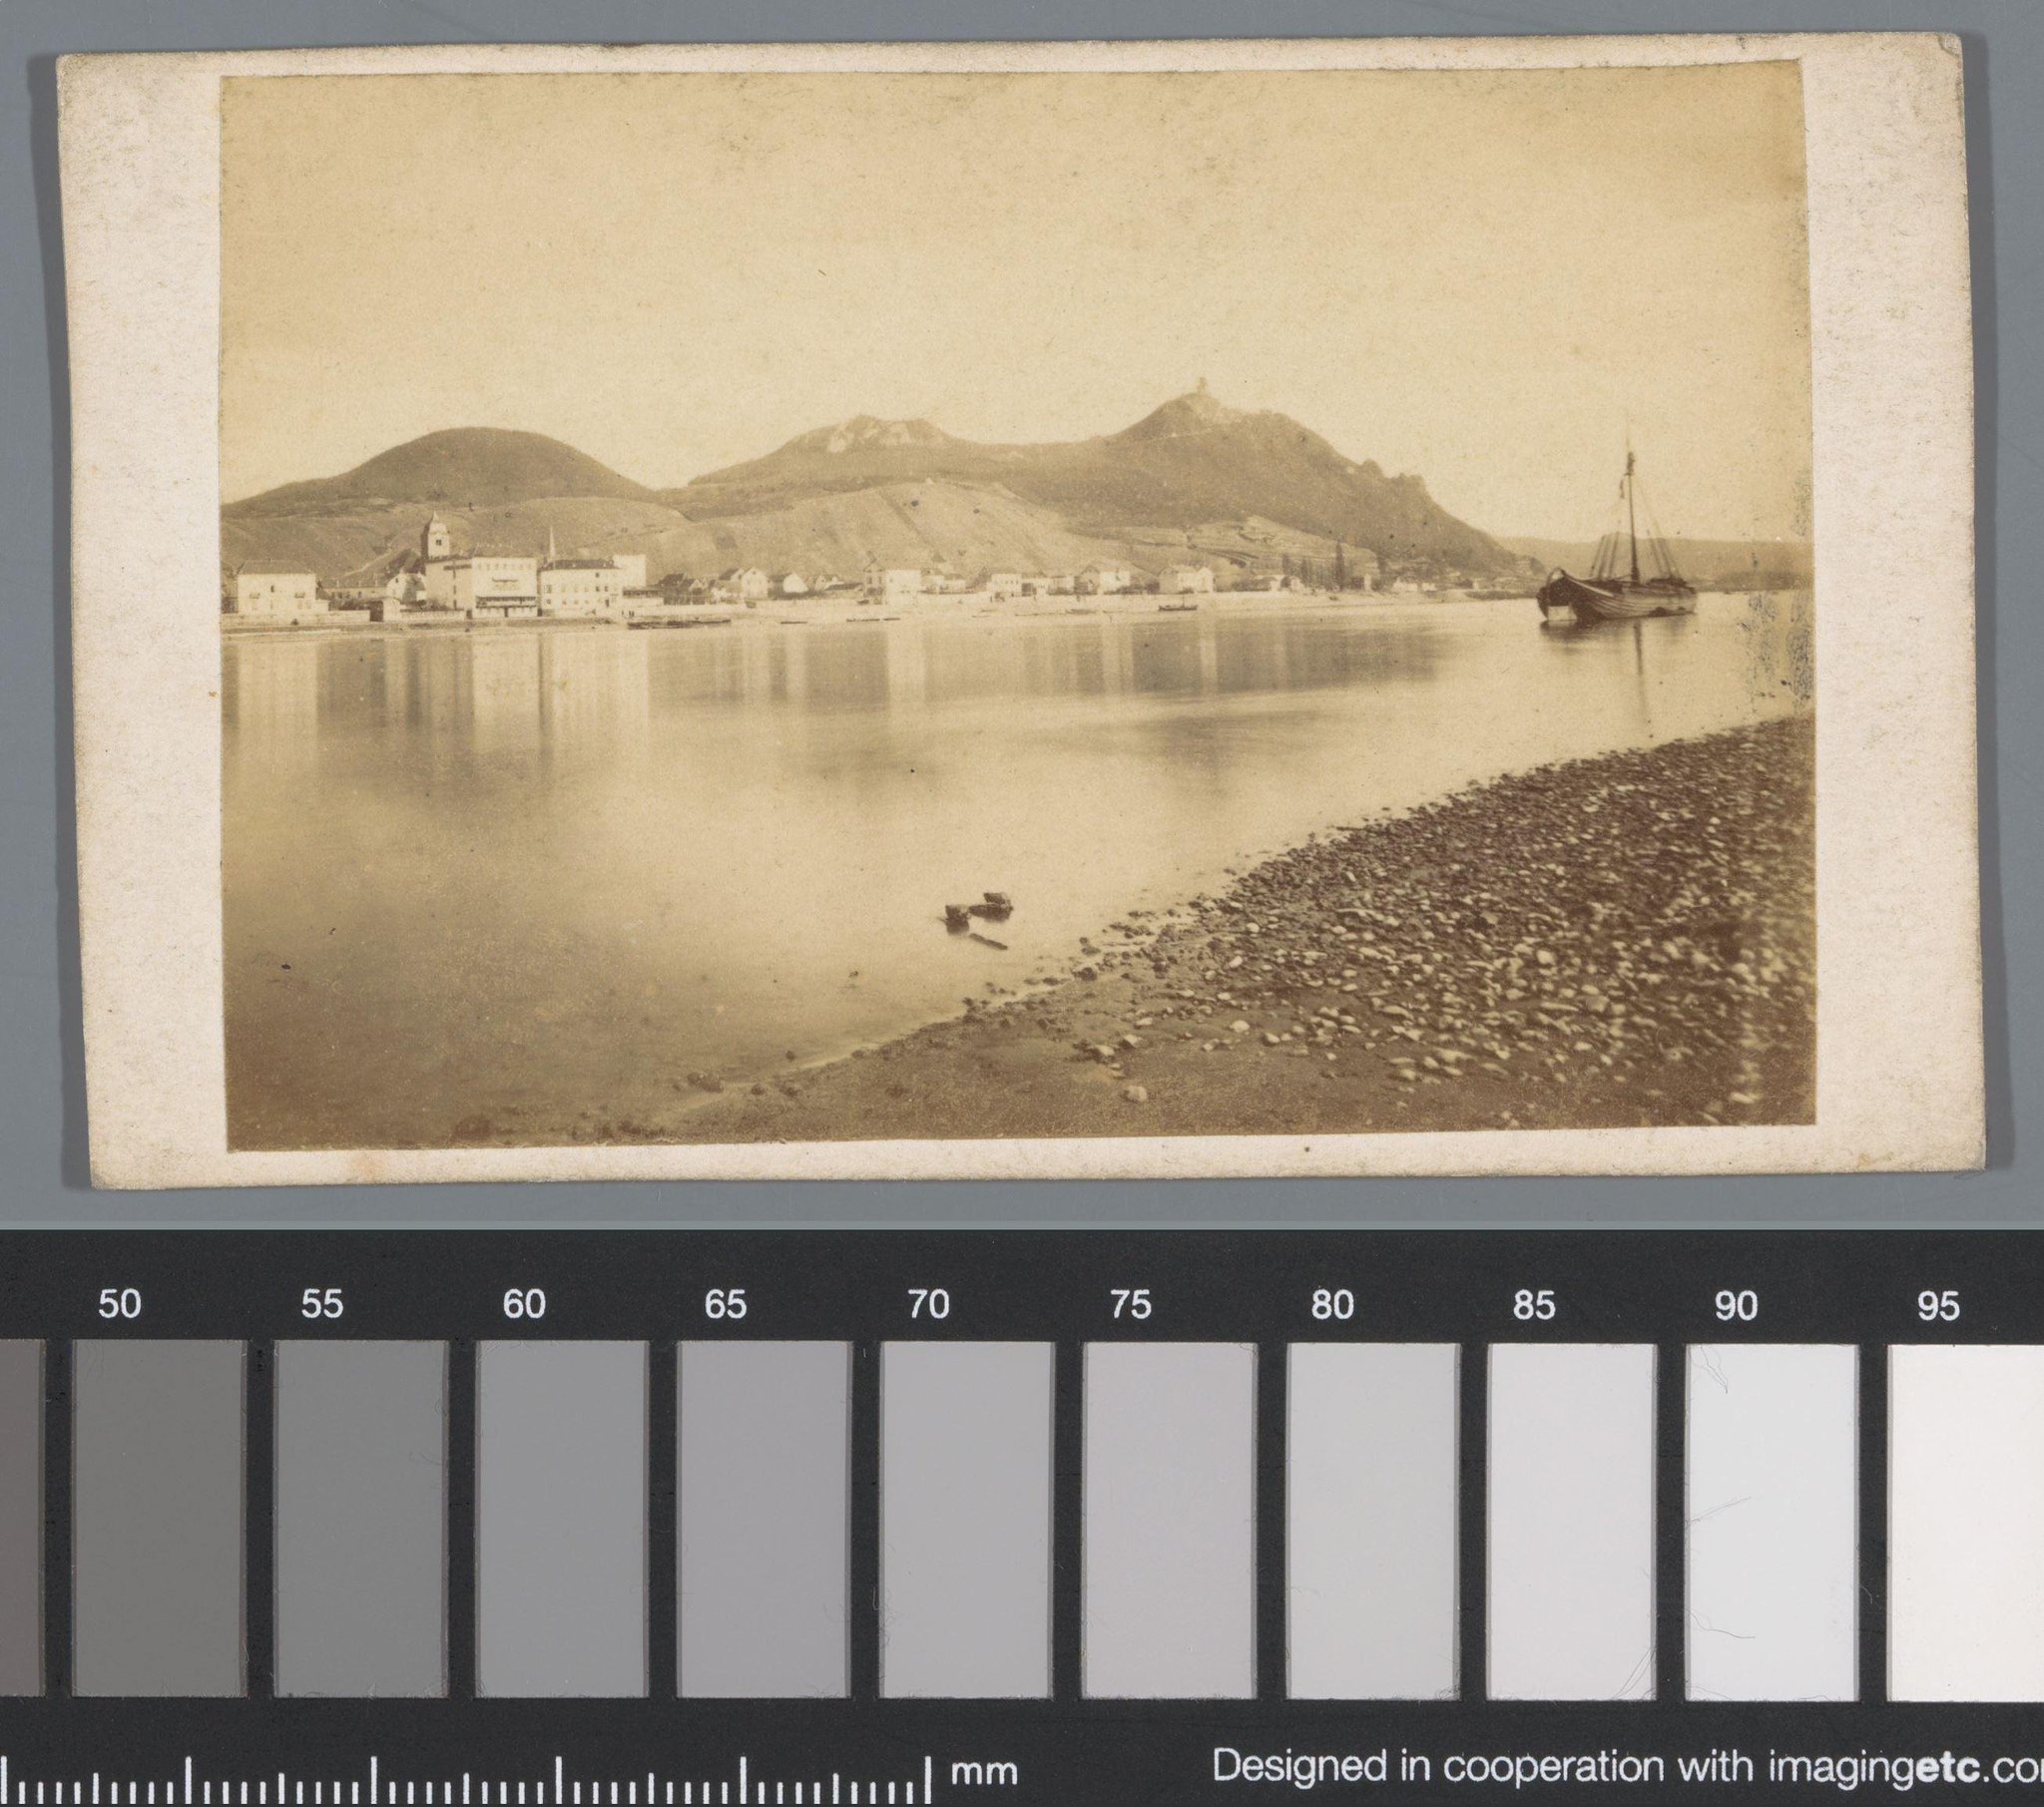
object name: photograph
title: Königswinter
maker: Anonymous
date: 1855-1885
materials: cardboard, paper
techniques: albumen print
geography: königswinter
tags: river, village